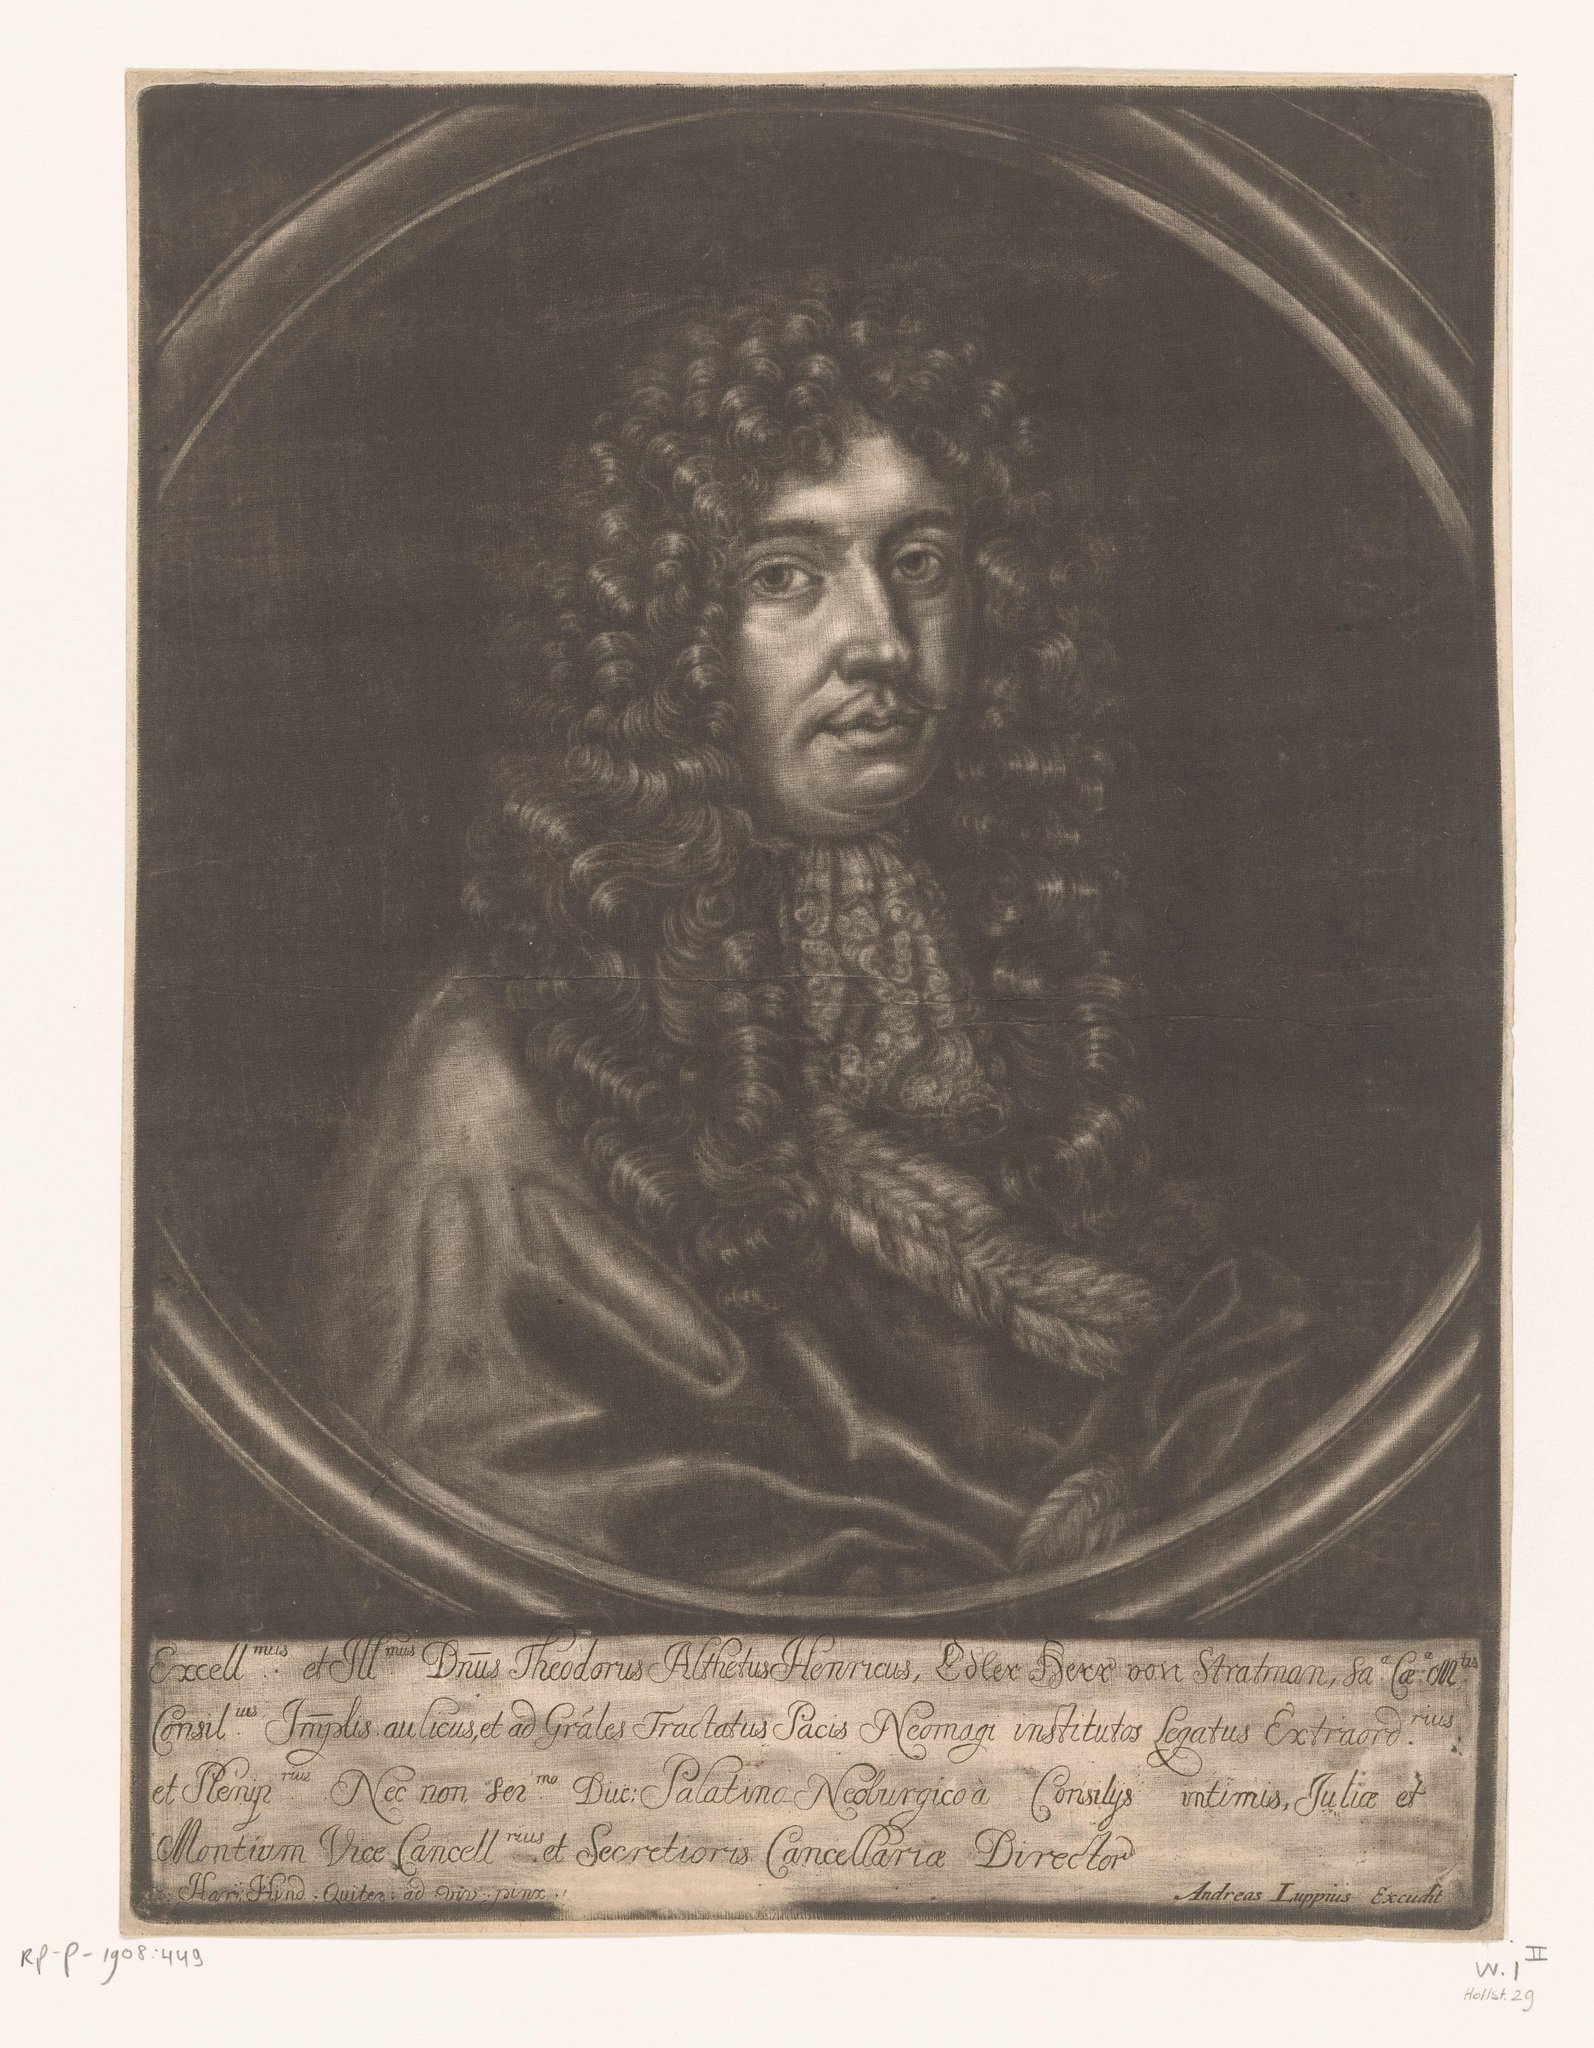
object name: print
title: Portret van Theodor Athlet Heinrich, graaf Strattmann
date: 1679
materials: paper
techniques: mezzotint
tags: vienna, historical persons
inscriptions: collector's mark: Lugt 2228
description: Prent voor het eerst gebruikt in: Quiter, Hermann Hendrik. Icones legatorum (...). Nijmegen: s.n., 1679.